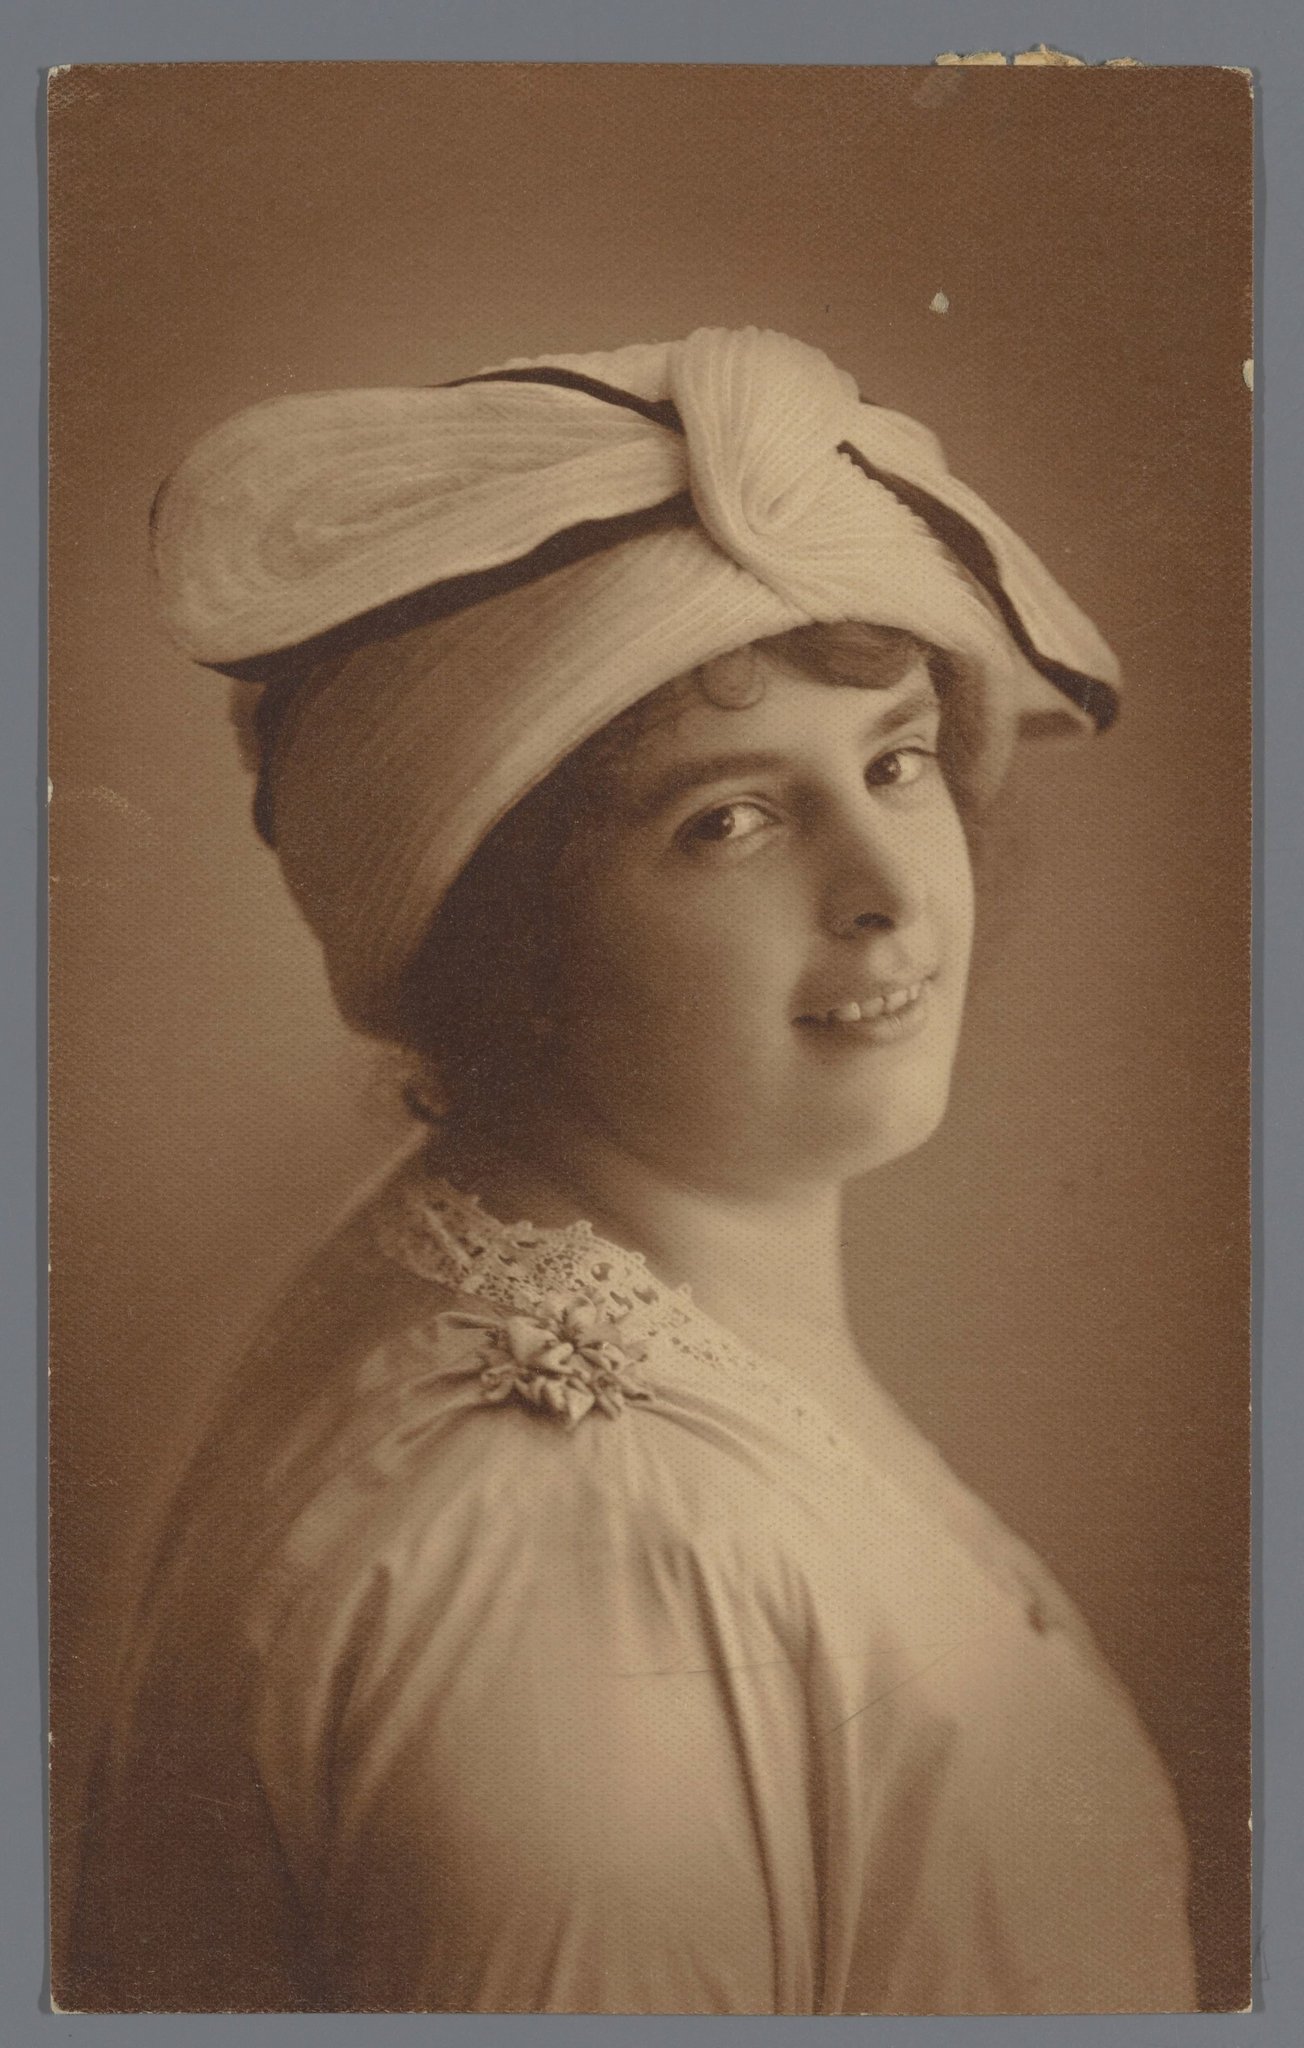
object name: photograph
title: Portret van een onbekende vrouw met een tulband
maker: Anonymous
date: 1920-1935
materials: photographic support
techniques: gelatin silver print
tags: adult woman, head-gear: turban